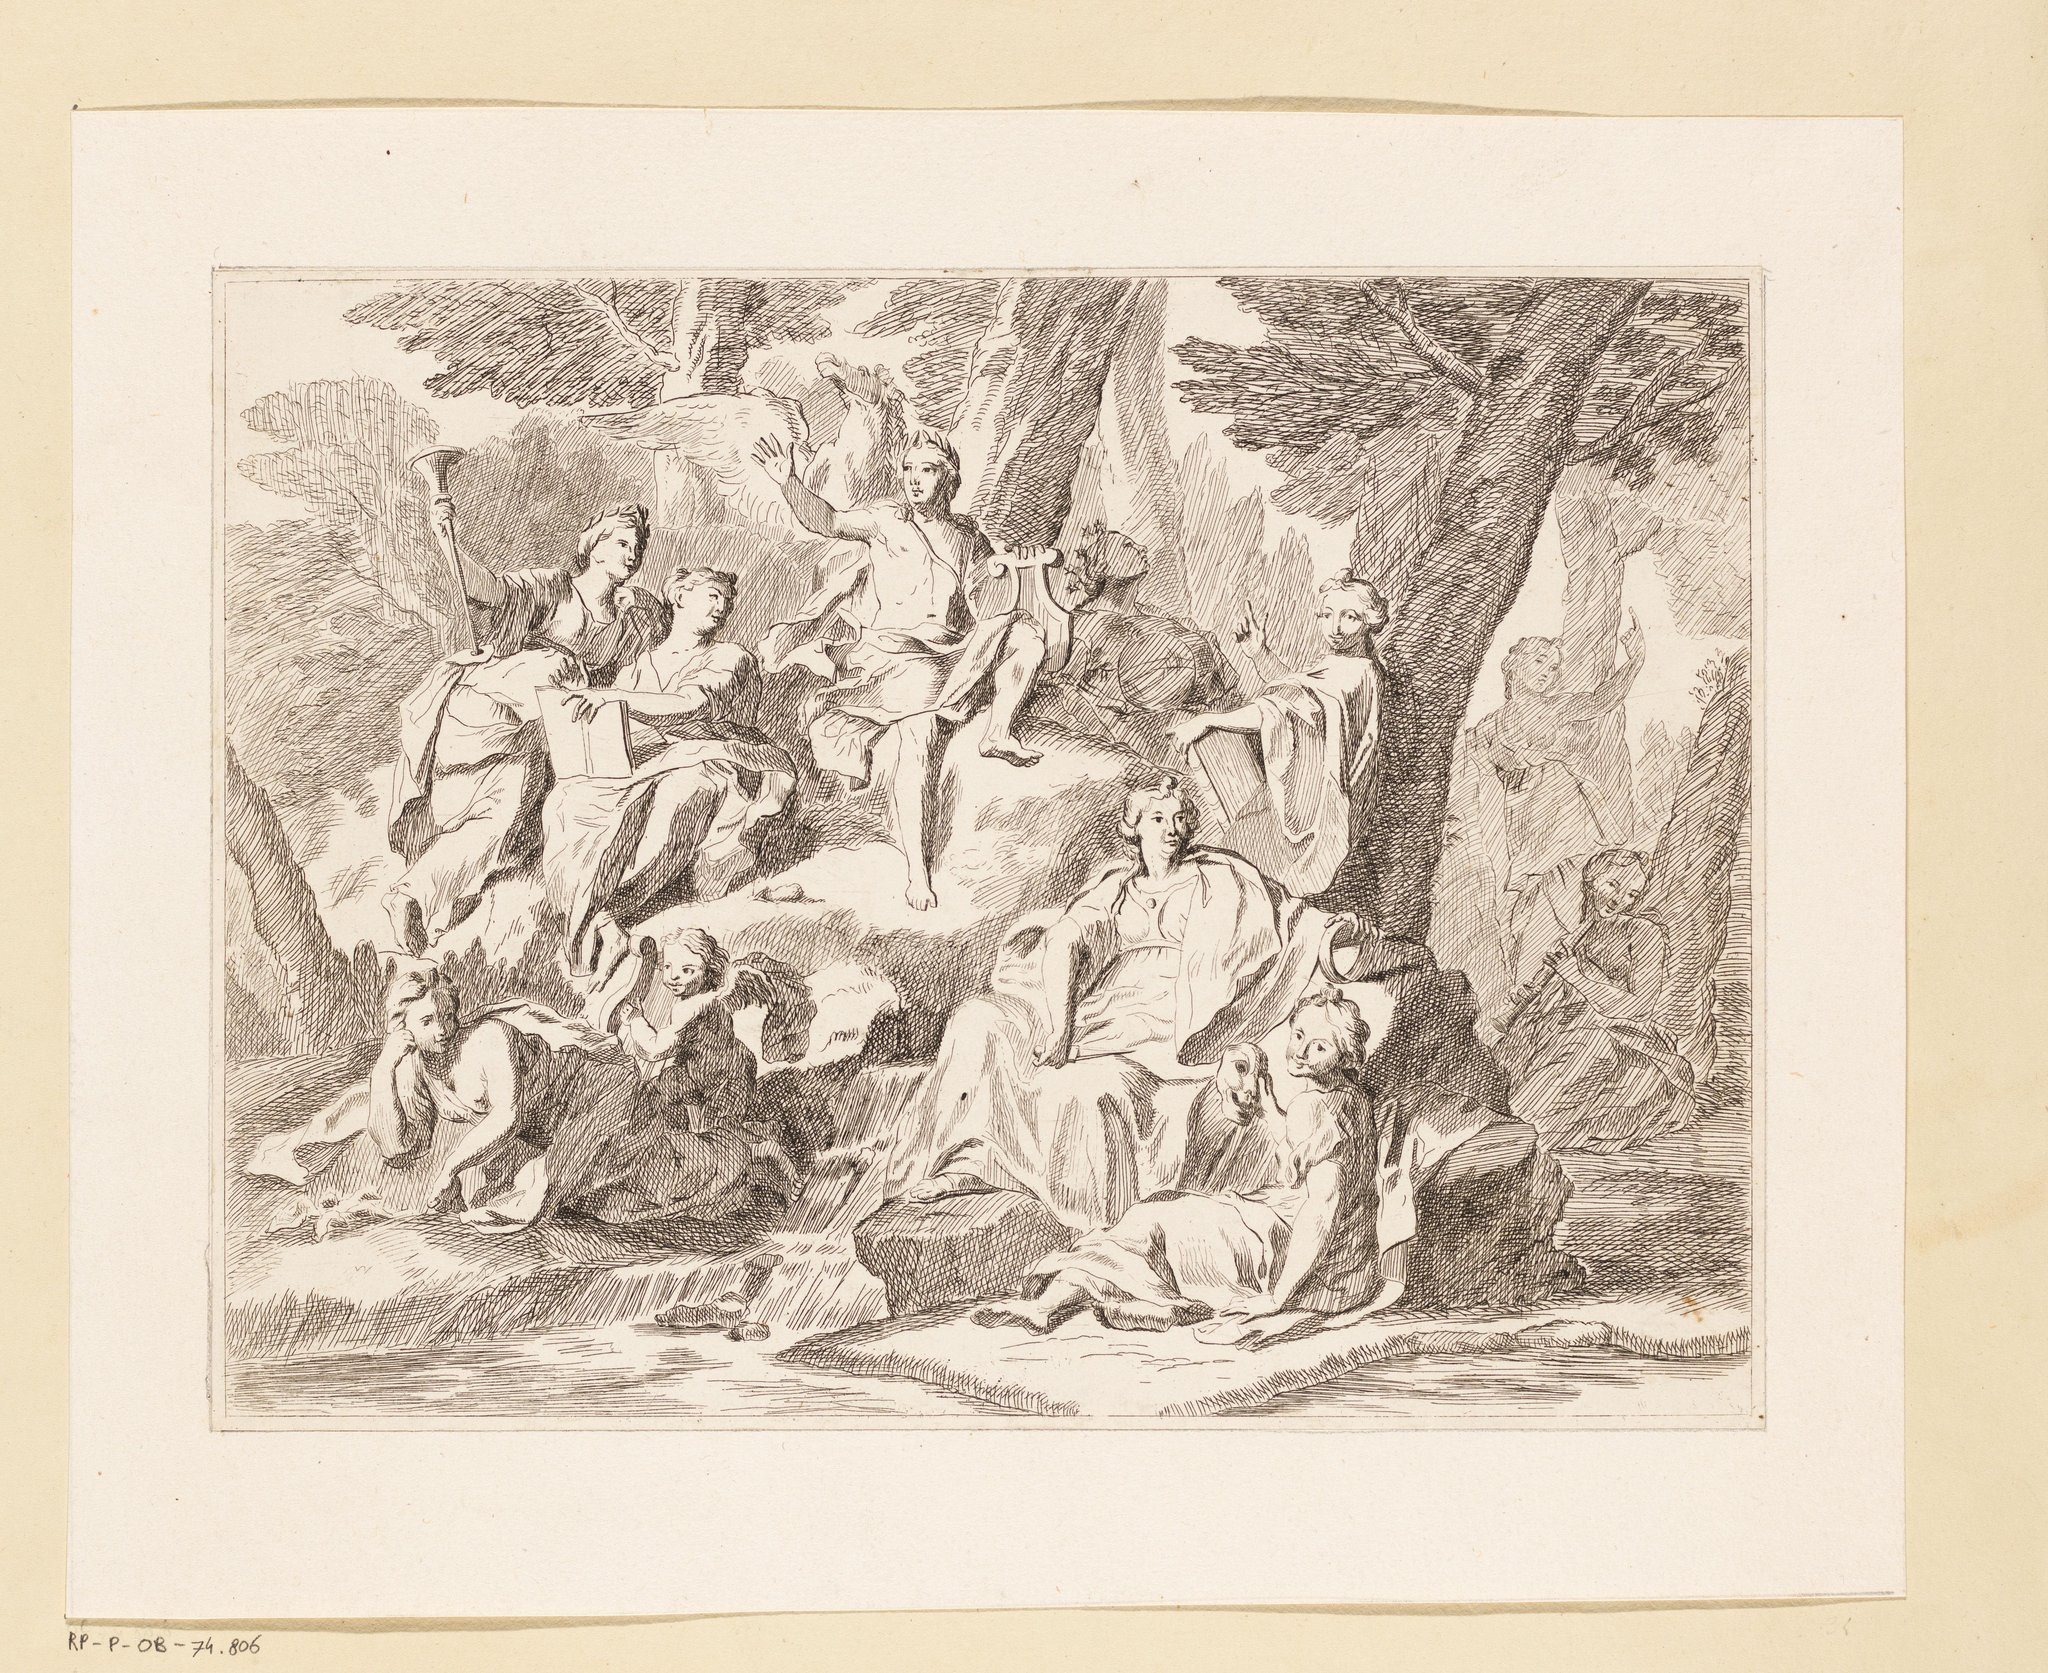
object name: print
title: Apollo en de muzen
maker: lodewijk van frankrijk (hertog van bourgondië)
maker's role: hertog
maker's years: 1682-1712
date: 1697-1712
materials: paper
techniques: etching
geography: france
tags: apollo and the muses, apollo musagetes, (story of) apollo (phoebus)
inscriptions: collector's mark: Lugt 240